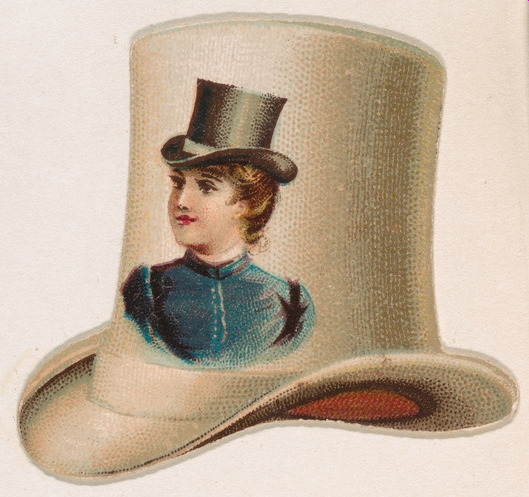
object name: print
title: Top hat, from the Novelties series (N228, Type 3) issued by Kinney Bros.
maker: kinney brothers tobacco company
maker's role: publisher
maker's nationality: american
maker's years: 1869-2011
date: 1889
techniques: color lithograph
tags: hats,women